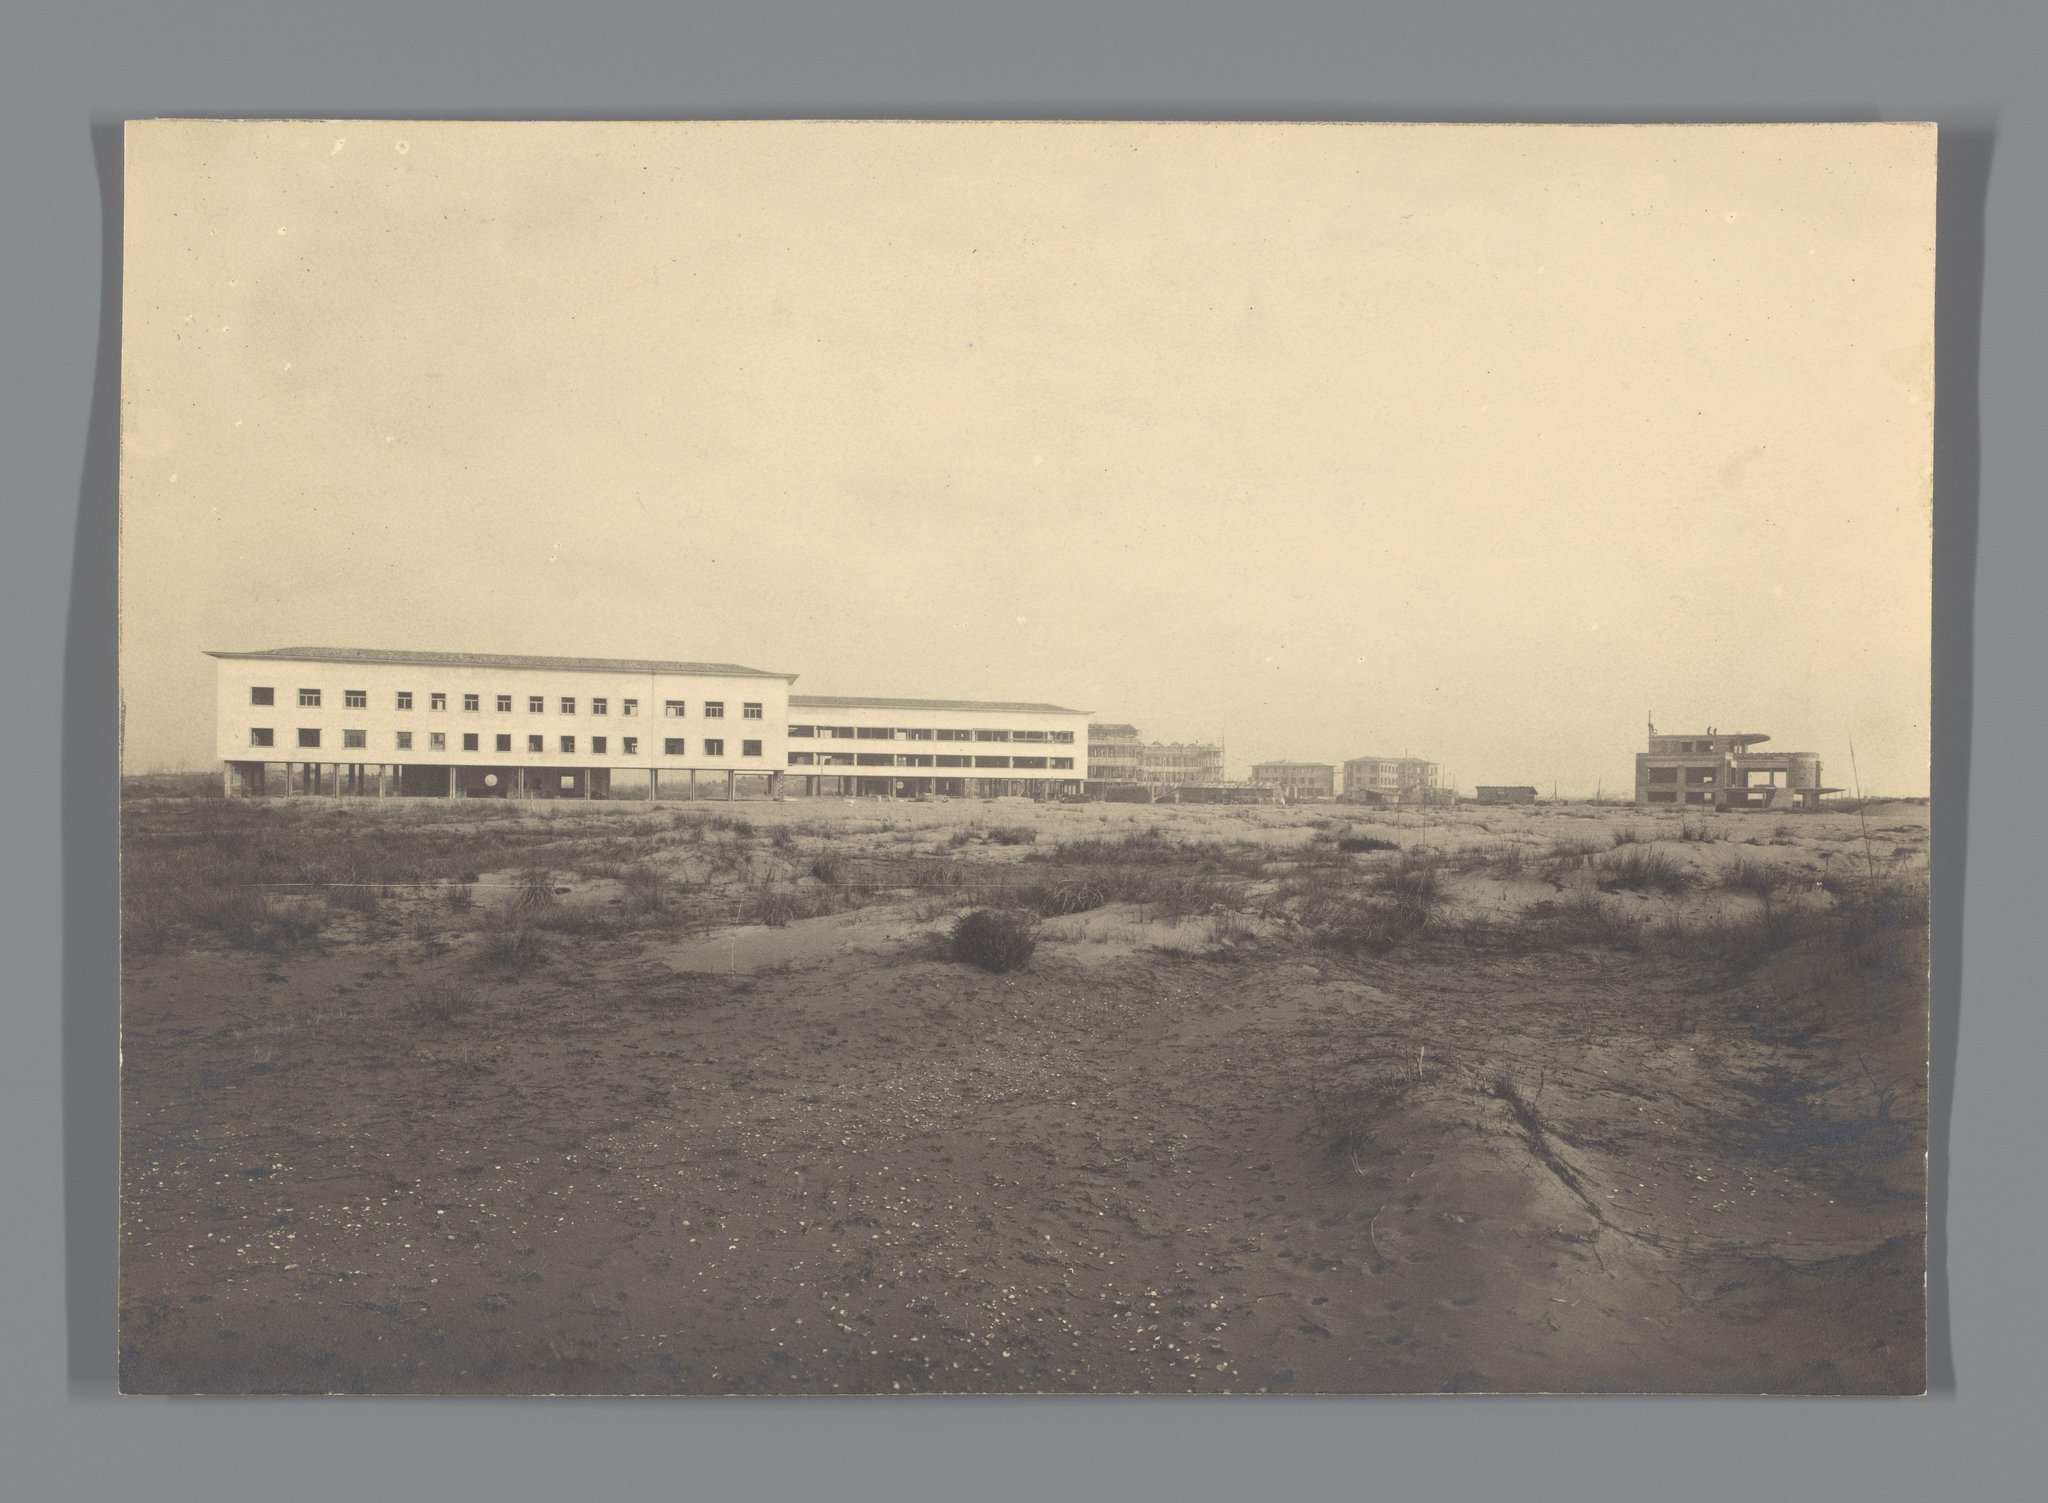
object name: photograph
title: Italië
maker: Anonymous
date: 1880-1910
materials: photographic support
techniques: albumen print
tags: italy